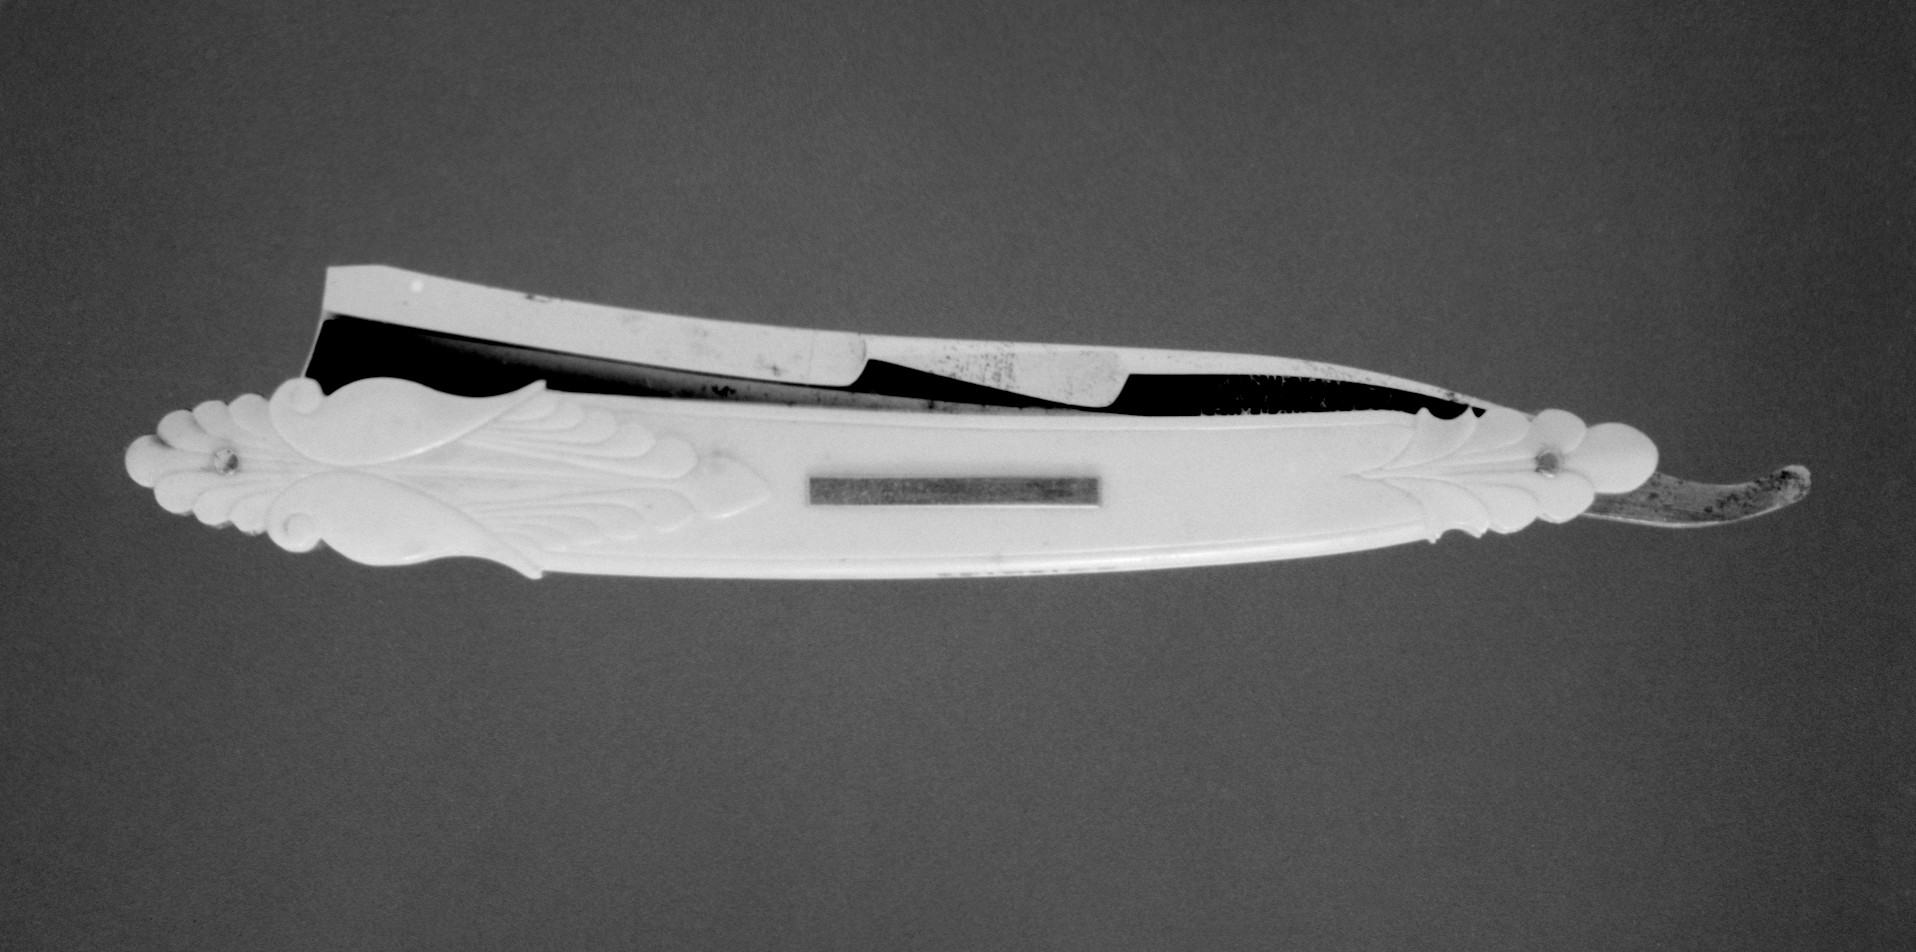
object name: razor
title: Four razors with ivory handles (part of a set)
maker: hawcroft & pearson, england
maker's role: maker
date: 1848-1849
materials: ivory, steel